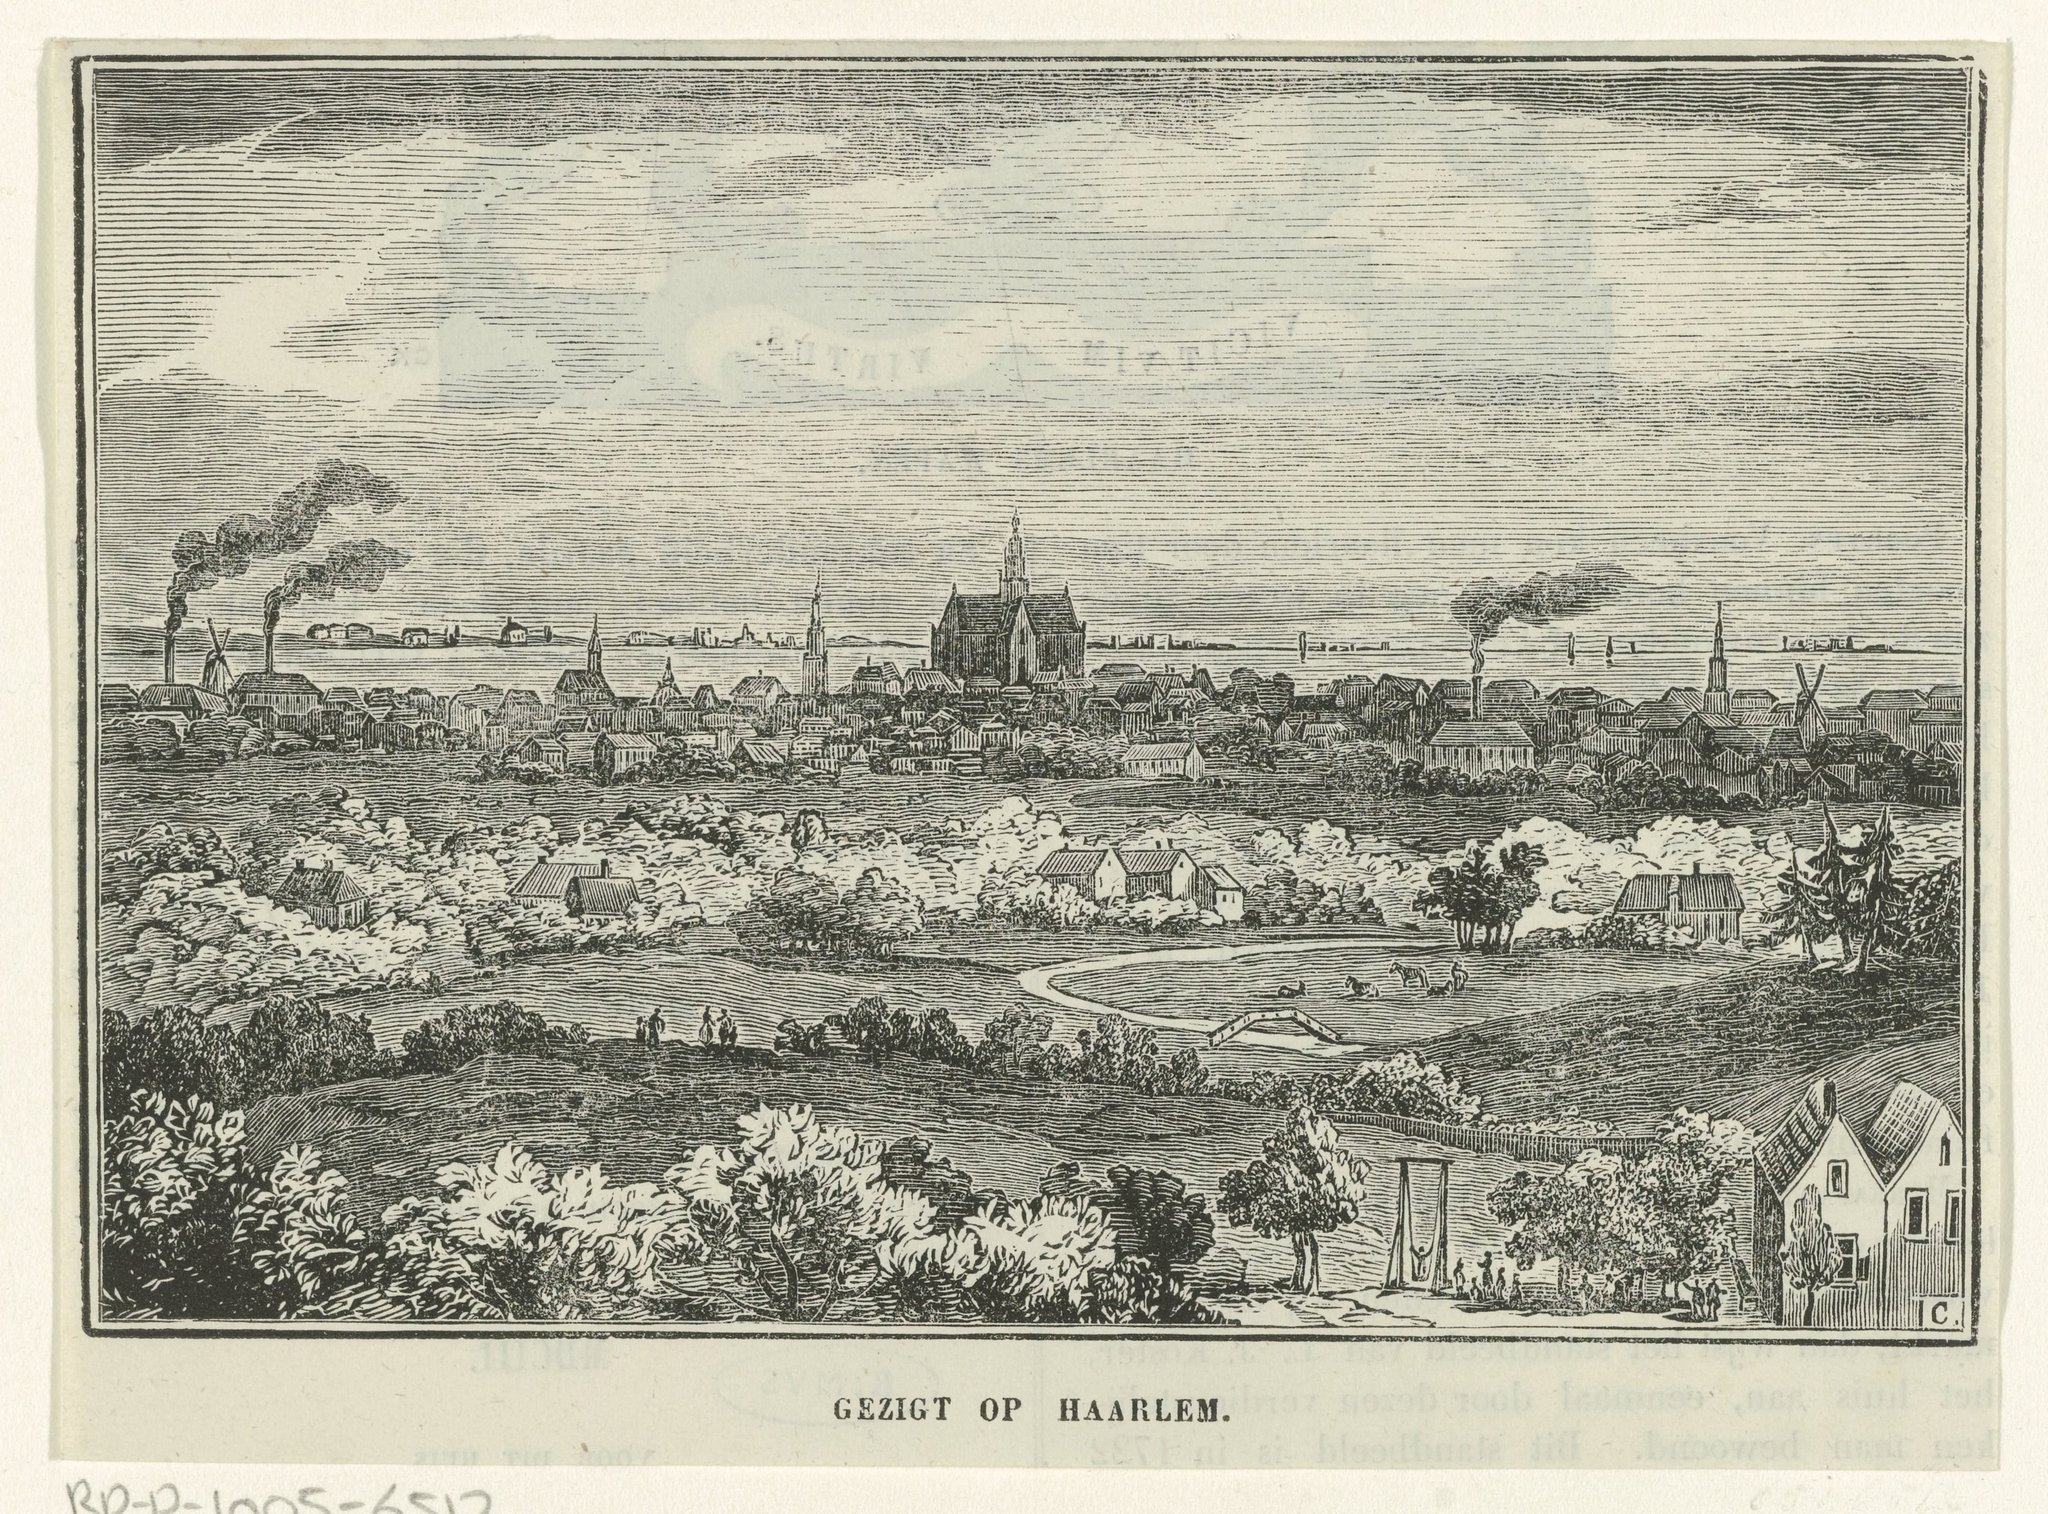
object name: print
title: Gezigt op Haarlem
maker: alexander cranendoncq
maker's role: draughtsman, print maker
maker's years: 1799-1869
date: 1809-1869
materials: paper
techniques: letterpress printing, engraving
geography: netherlands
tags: village, haarlem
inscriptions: collector's mark: Lugt 2228